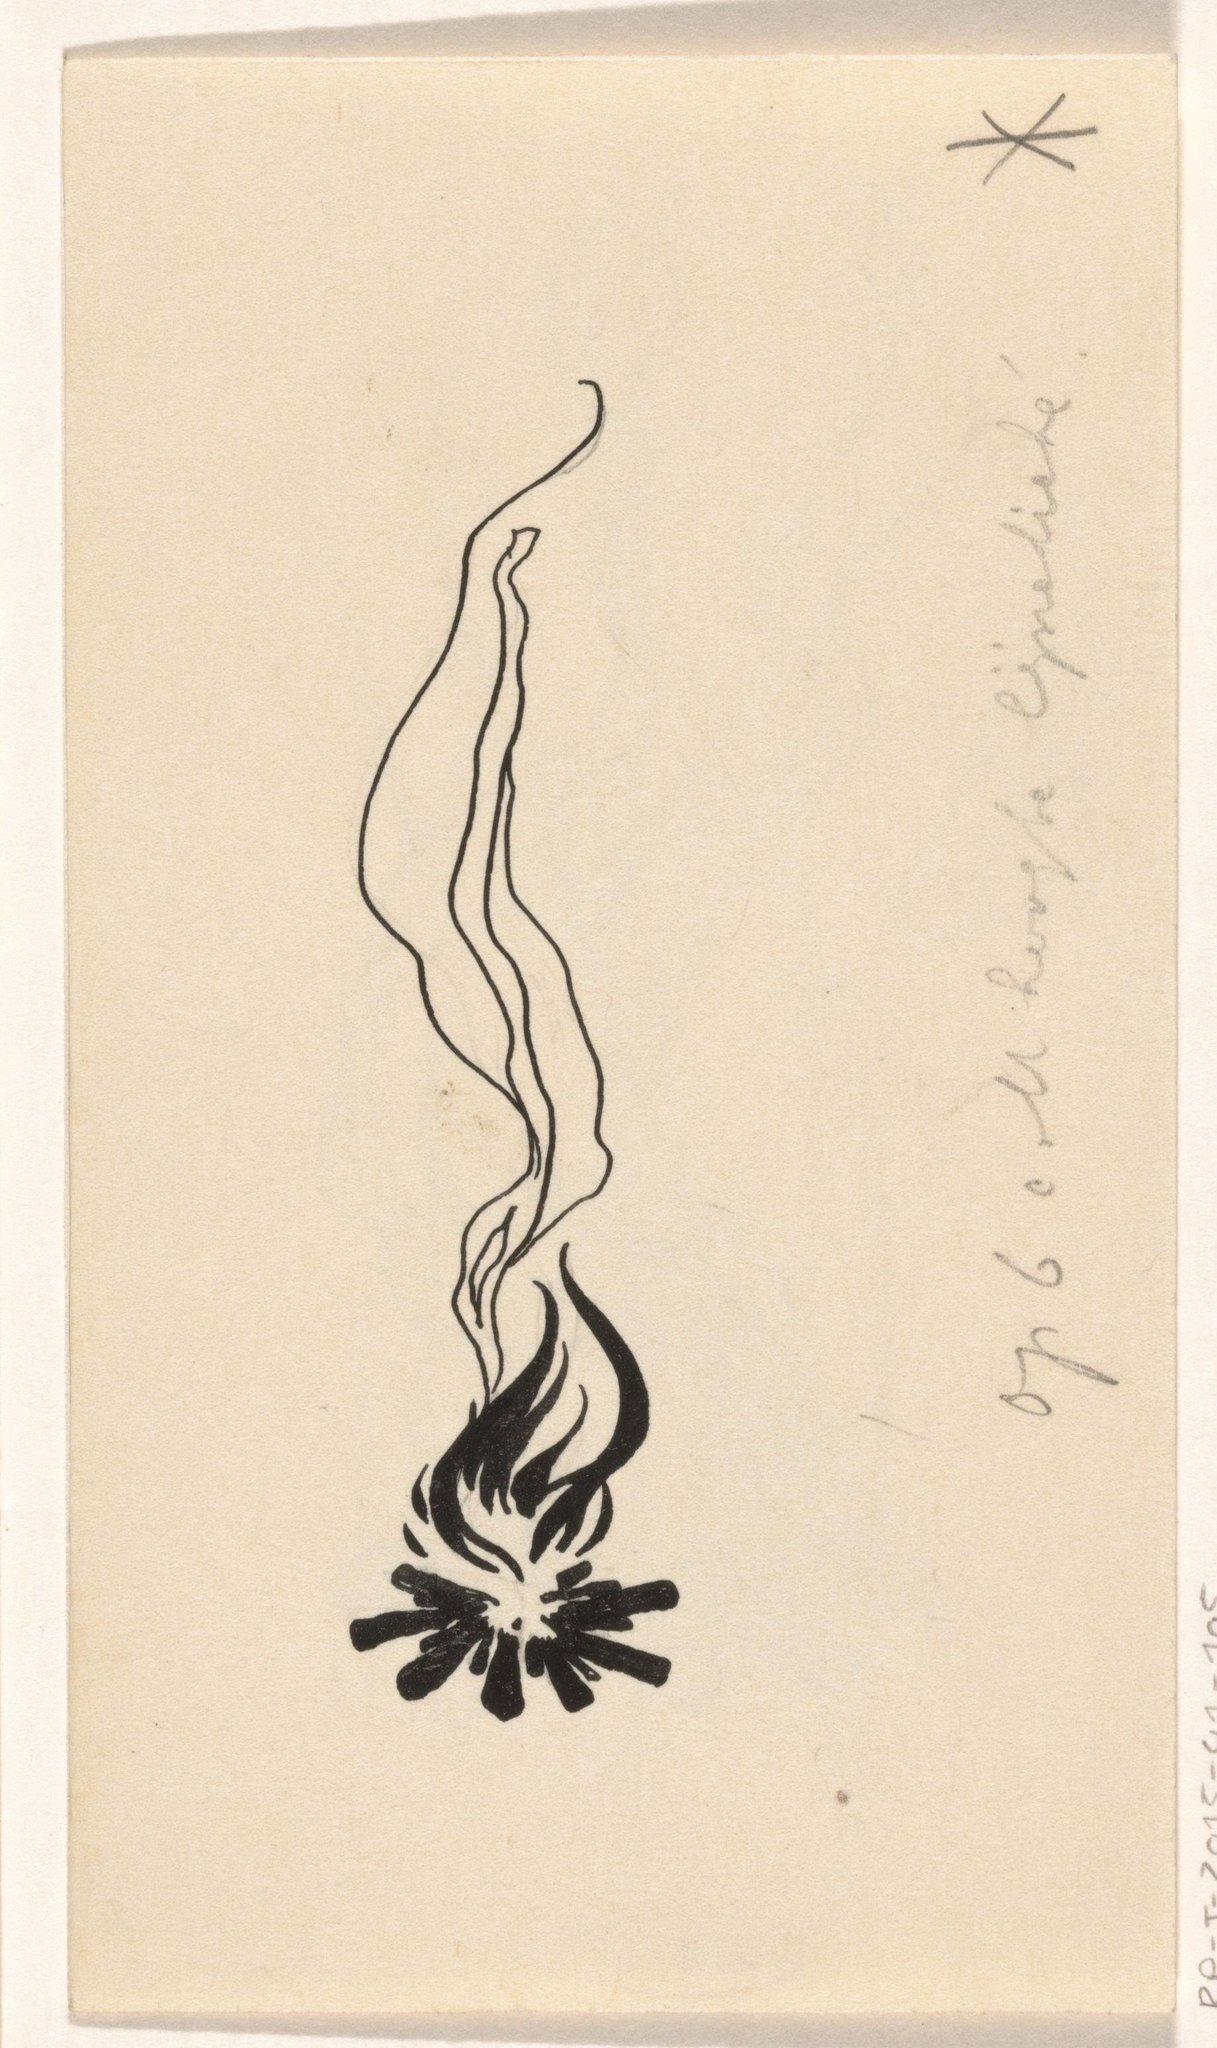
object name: drawing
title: Bloem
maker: hans borrebach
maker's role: draughtsman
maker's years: 1903-1991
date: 1913-1970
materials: ink, paper, pencil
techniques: brush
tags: flowers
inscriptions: collector's mark: Lugt 2228a, :, number:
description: Verso een doorgehaalde pentekening van een bloem.